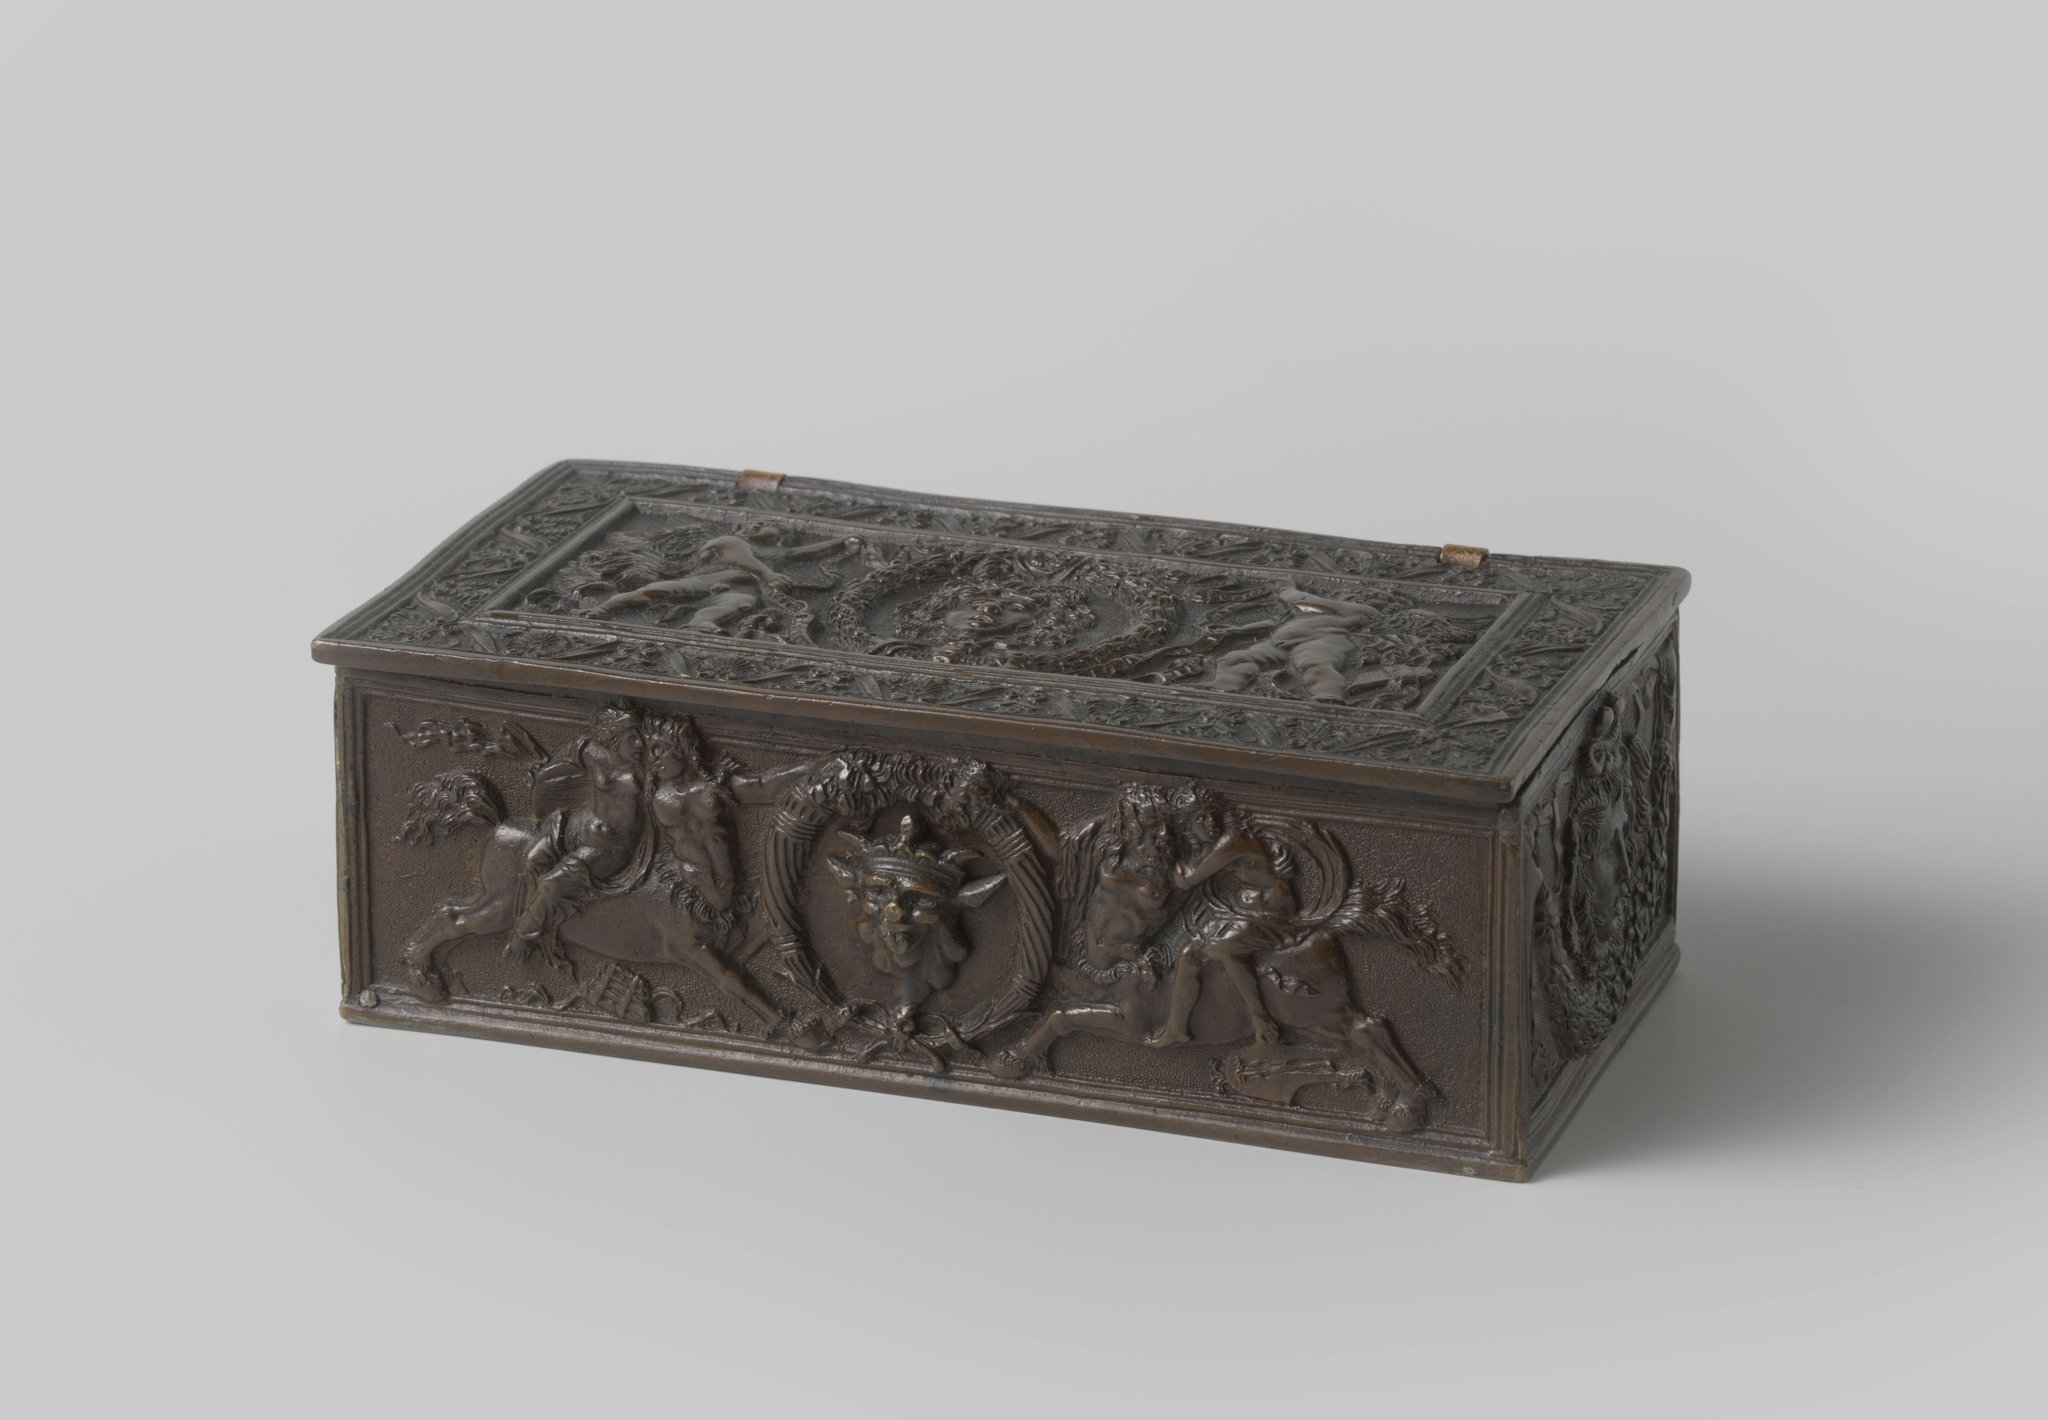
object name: sculpture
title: Kistje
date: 1500-1525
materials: bronze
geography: padua